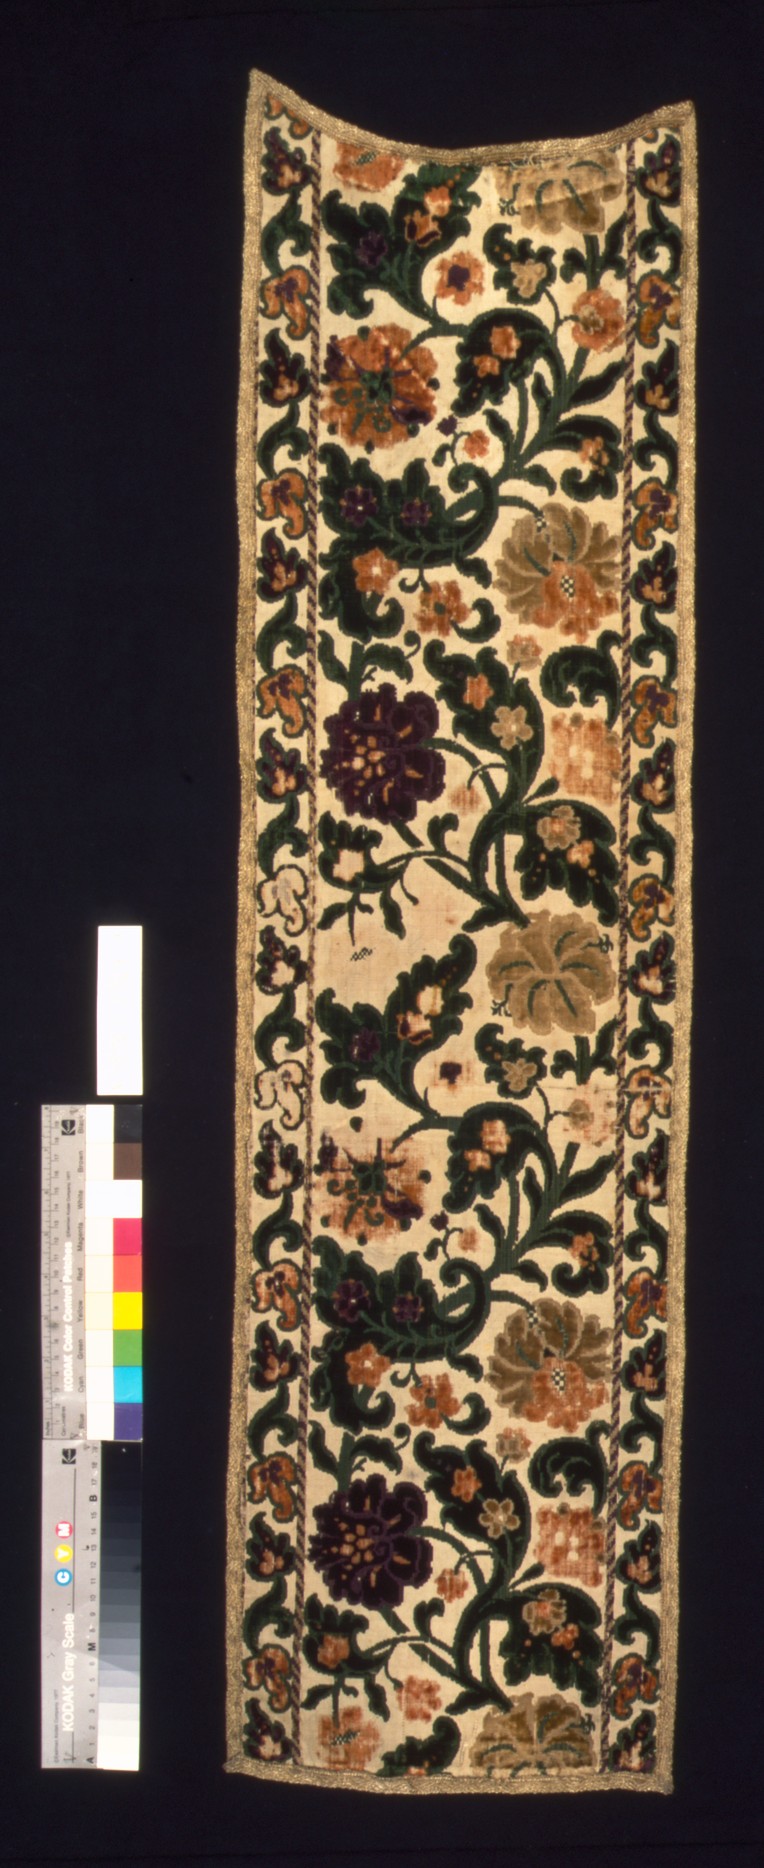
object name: orphrey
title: Orphrey from a Chasuble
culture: italian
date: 1601-1650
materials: linen, metal, silk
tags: flowers